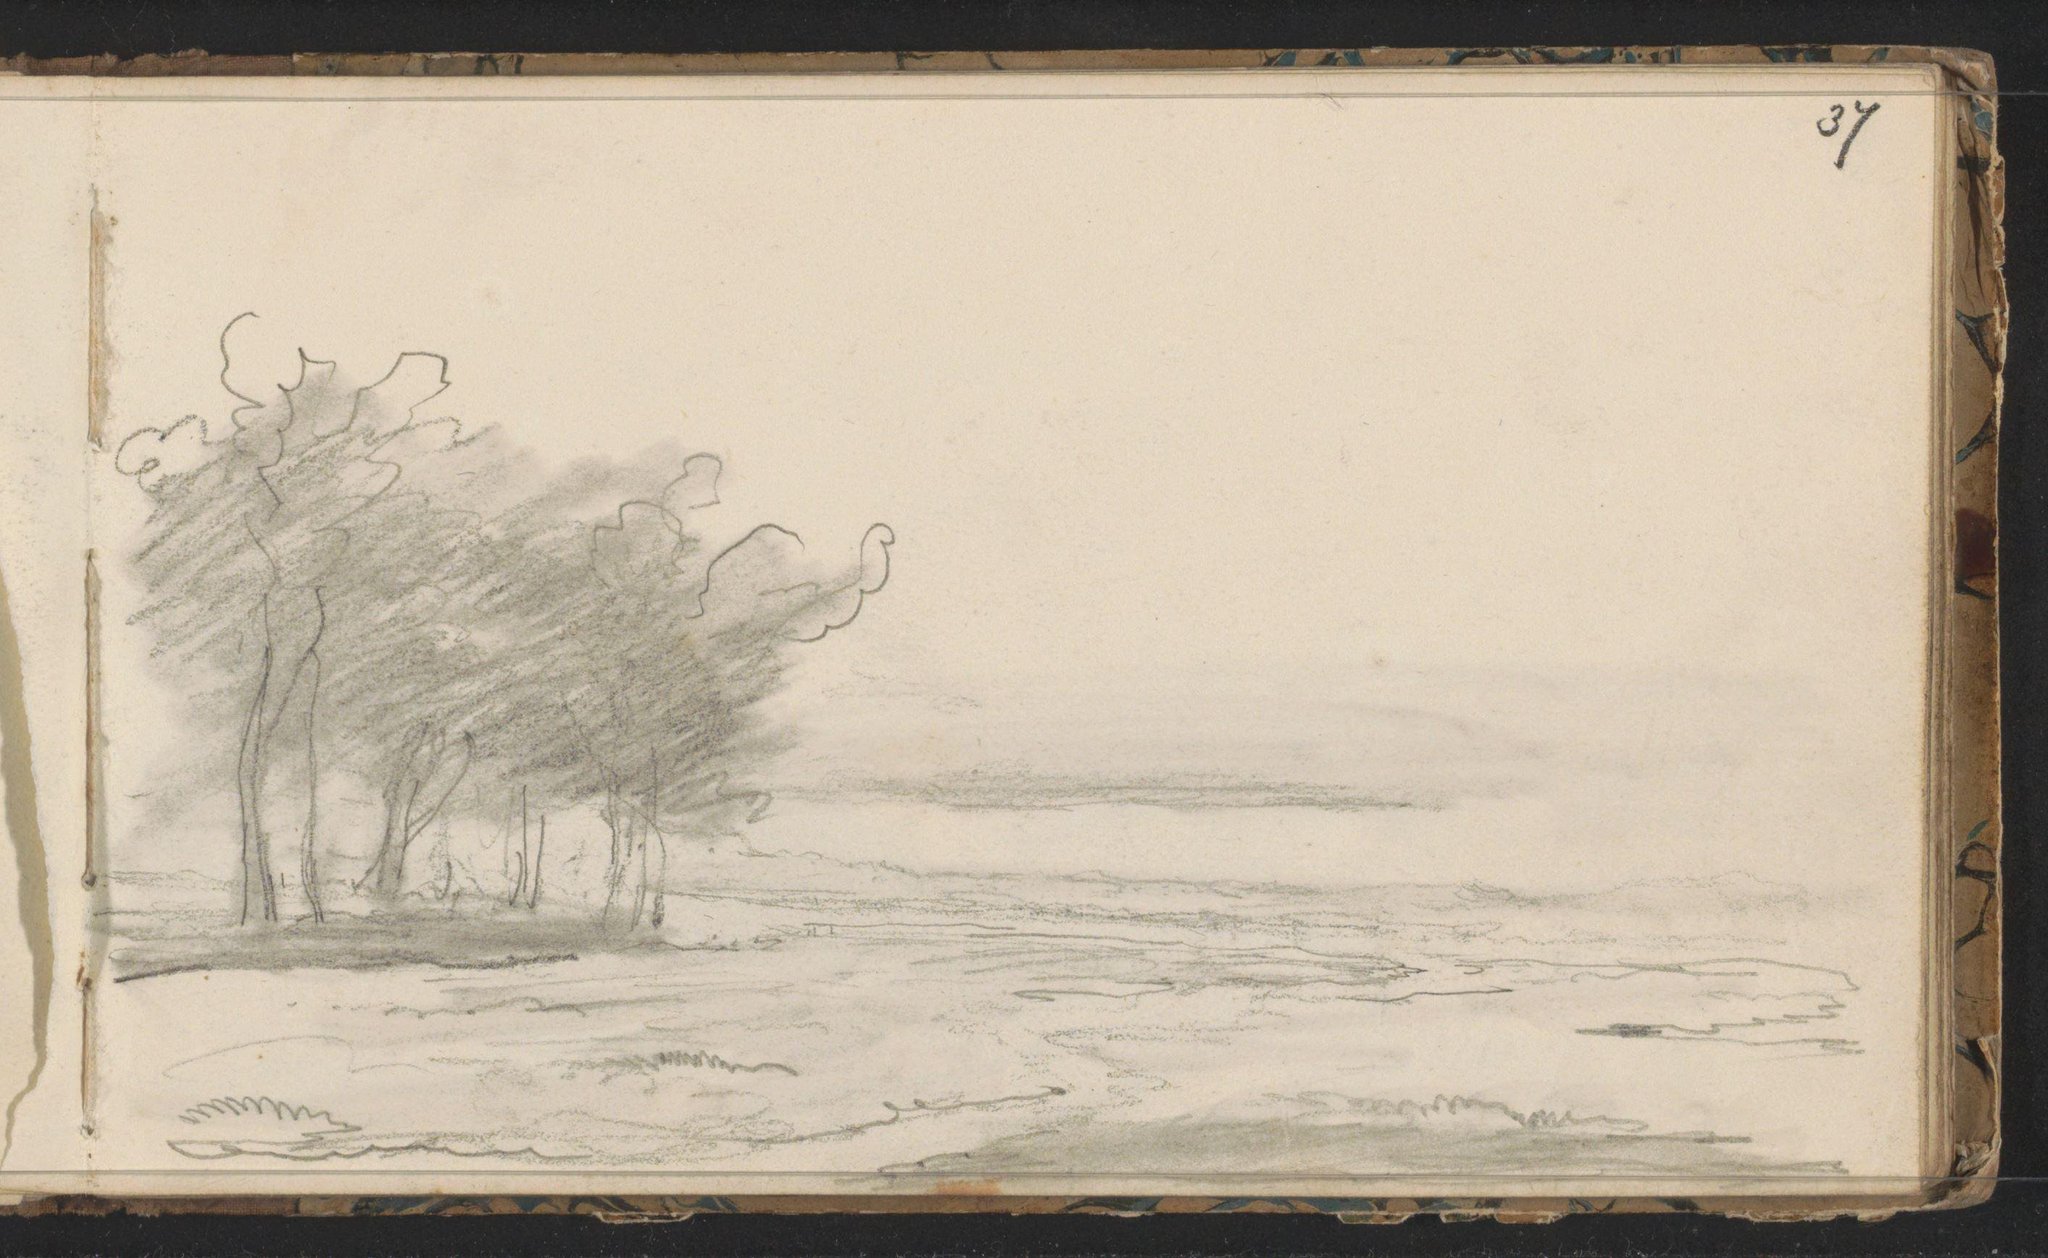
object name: sketchbook leaf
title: Landschap met bomen en water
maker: arnoldus johannes eymer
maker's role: draughtsman, print maker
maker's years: 1803-1863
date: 1803-1818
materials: paper, pencil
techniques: stumping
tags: trees, landscapes with waters, waterscapes, seascapes (in the temperate zone)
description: Bladzijde 37 uit een schetsboek met 74 bladzijden.